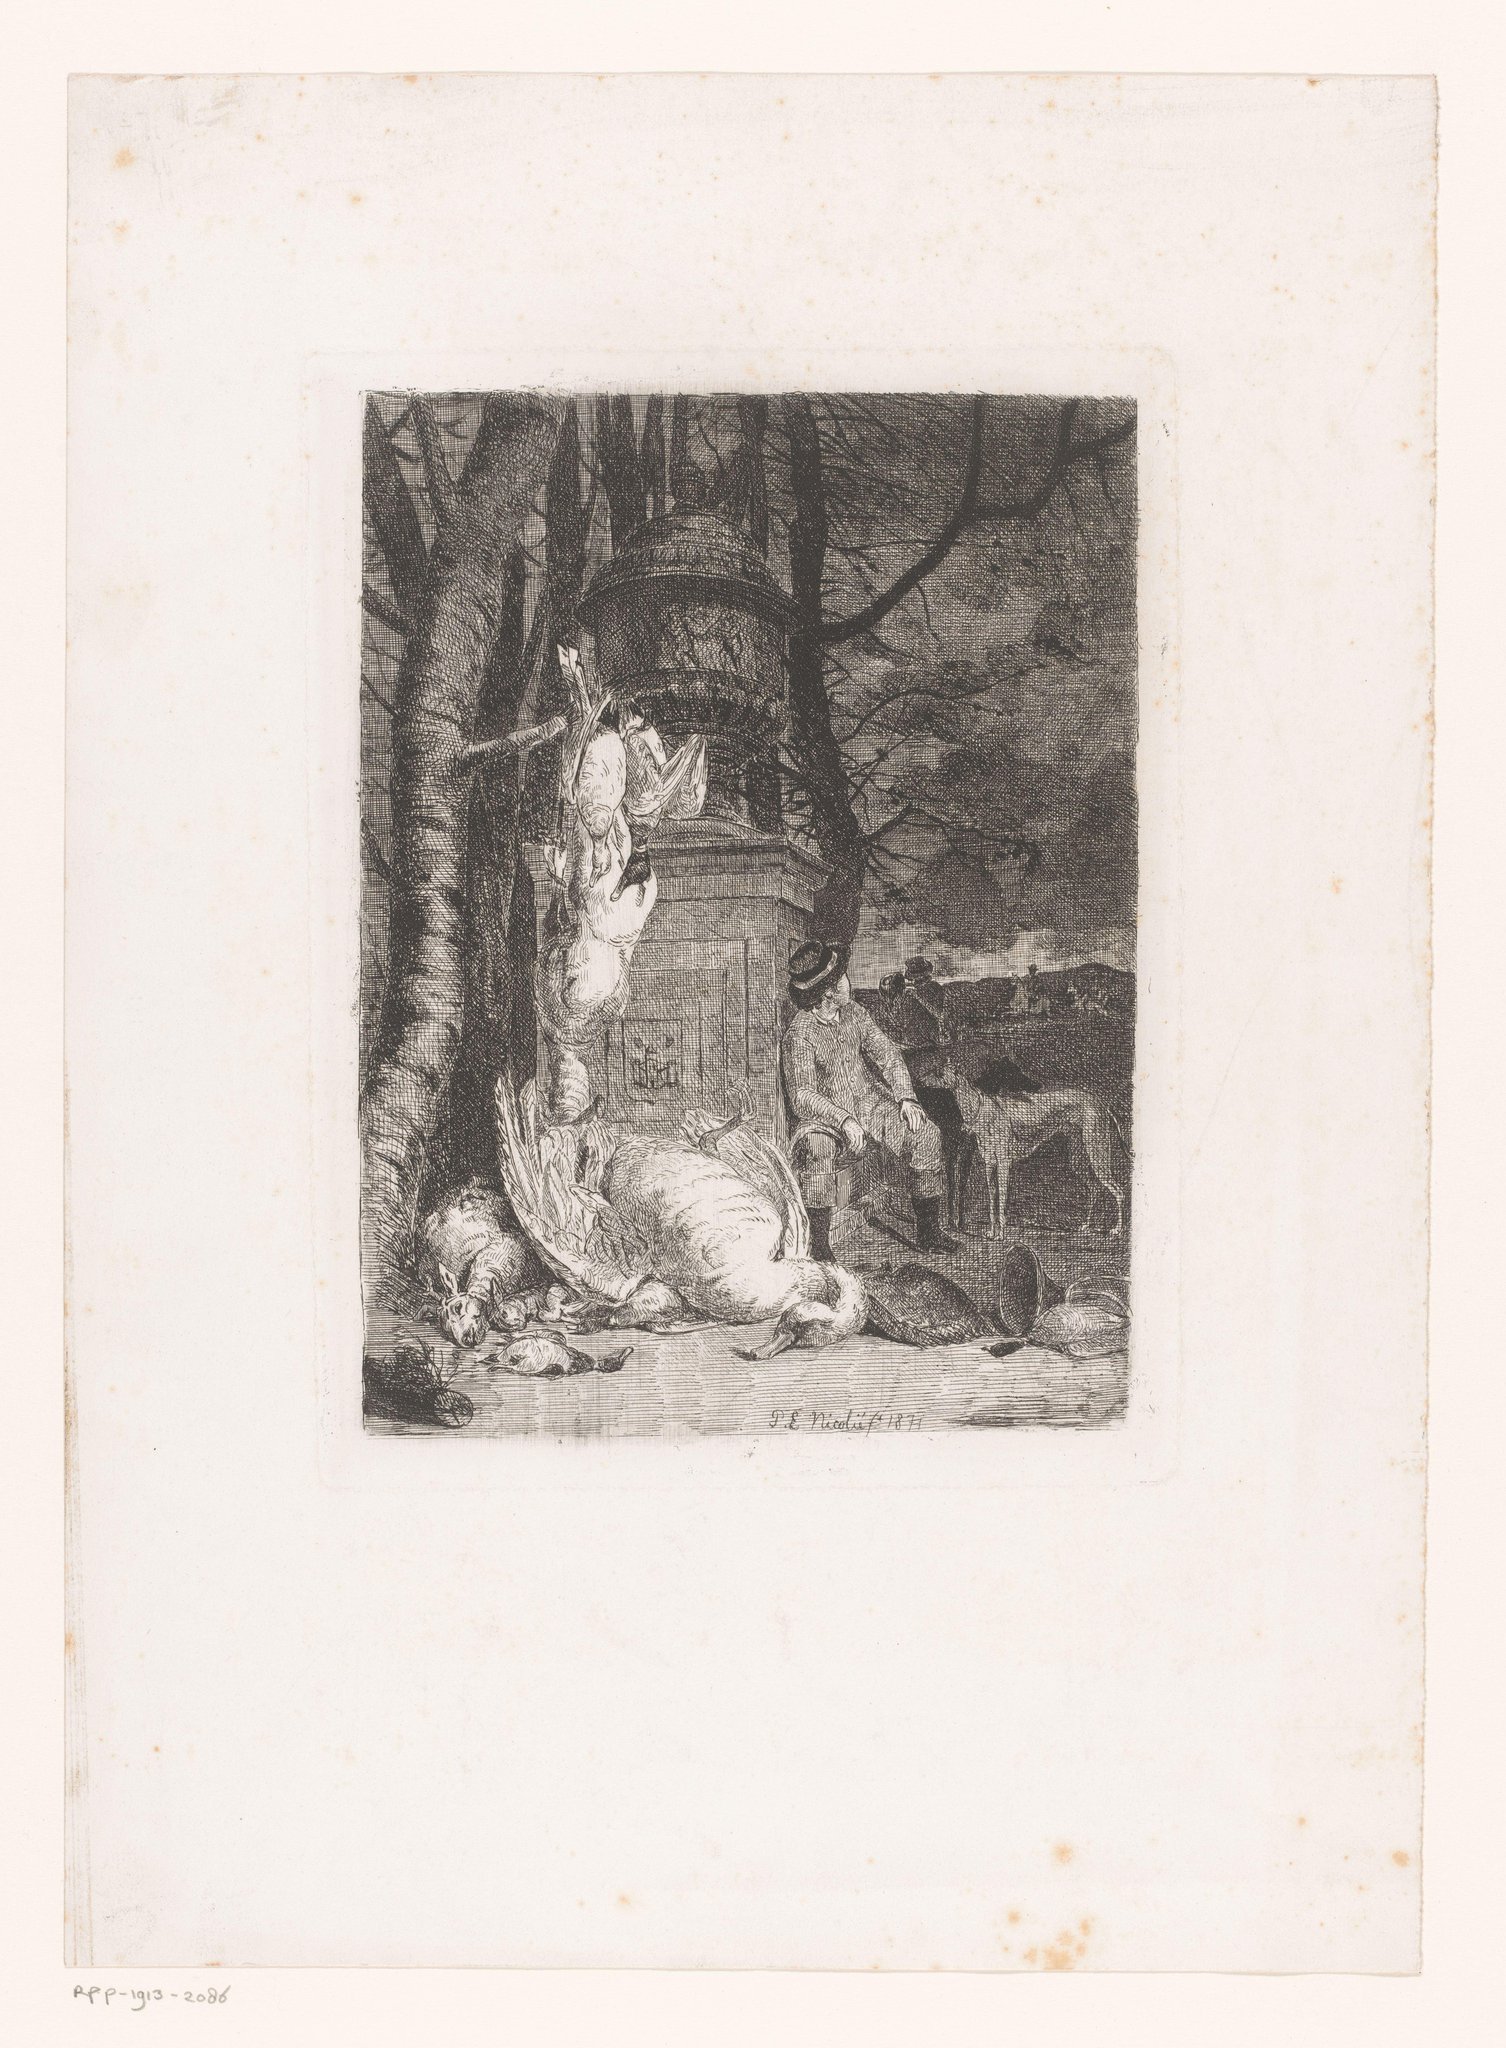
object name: print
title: Landschap met jagers bij de jachtbuit en een vaas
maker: paul emile nicolié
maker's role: print maker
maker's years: 1828-1894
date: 1871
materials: paper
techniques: etching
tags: water-birds: swan, hunter, vase ~ ornament, forest, wood, hunting trophies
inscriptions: collector's mark: Lugt 2228